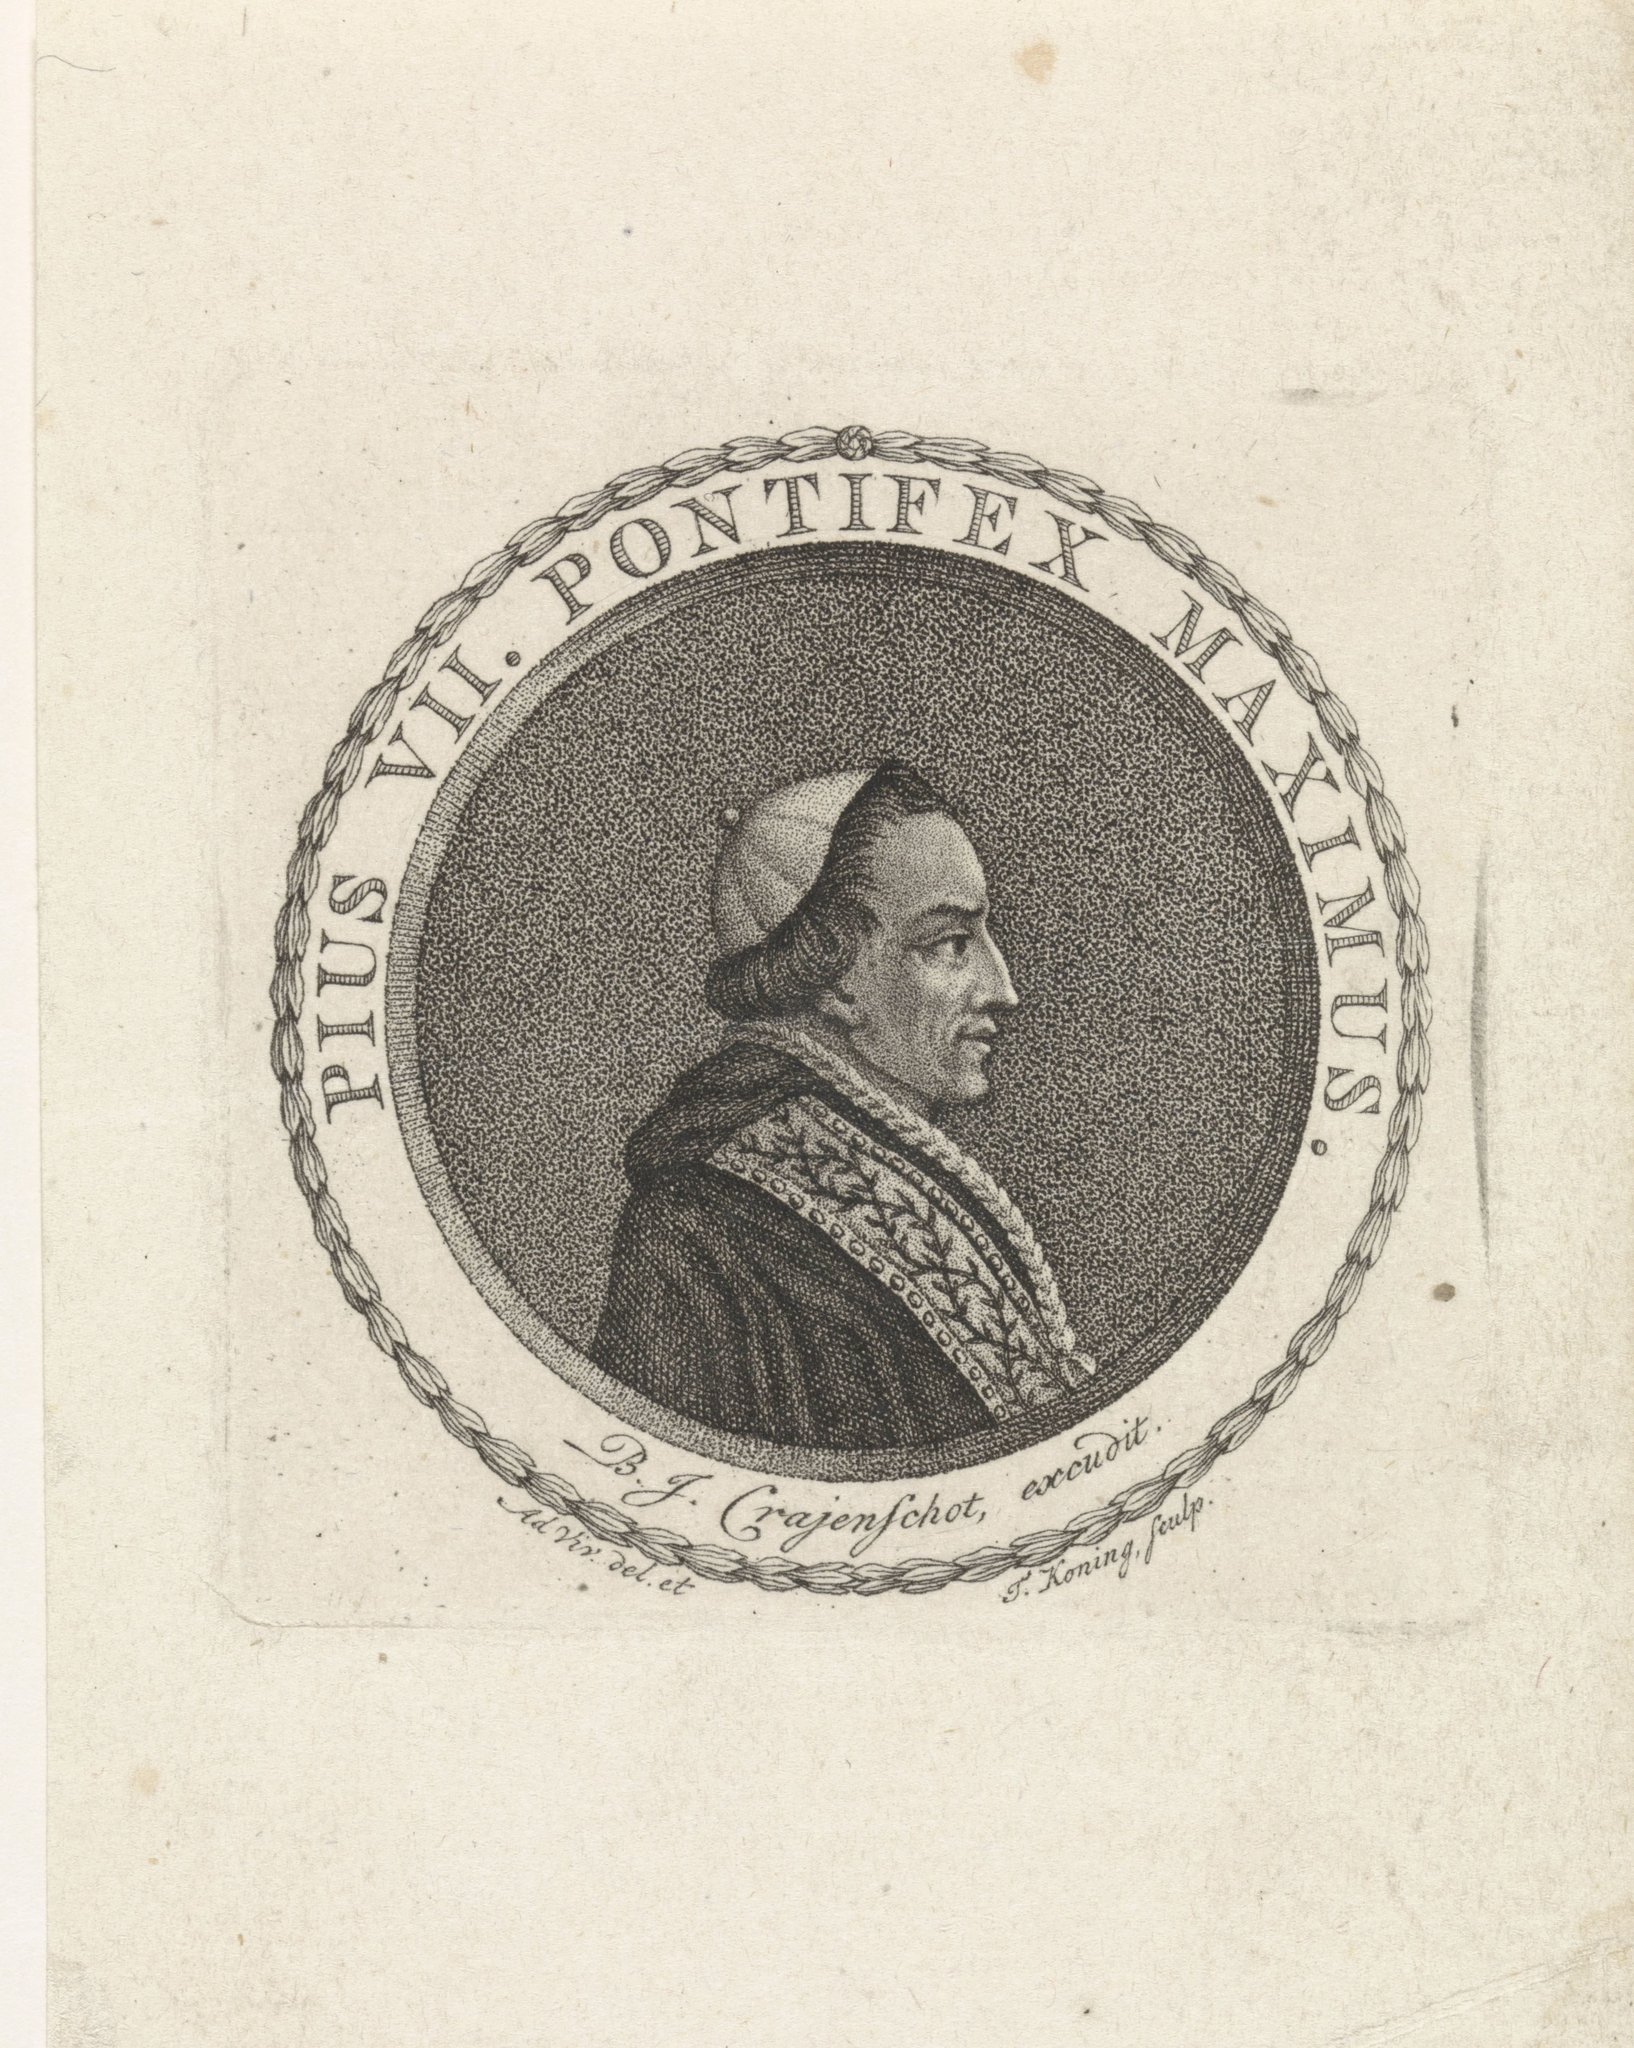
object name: print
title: Portret van paus Pius VII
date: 1800-1829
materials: paper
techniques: etching, engraving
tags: rome, clergyman, pius vii, historical persons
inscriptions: collector's mark: Lugt 2228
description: Portretbuste van paus Pius VII, dragende pauselijke kleding. In de cirkelvormige omlijsting de naam van de geportretteerde.